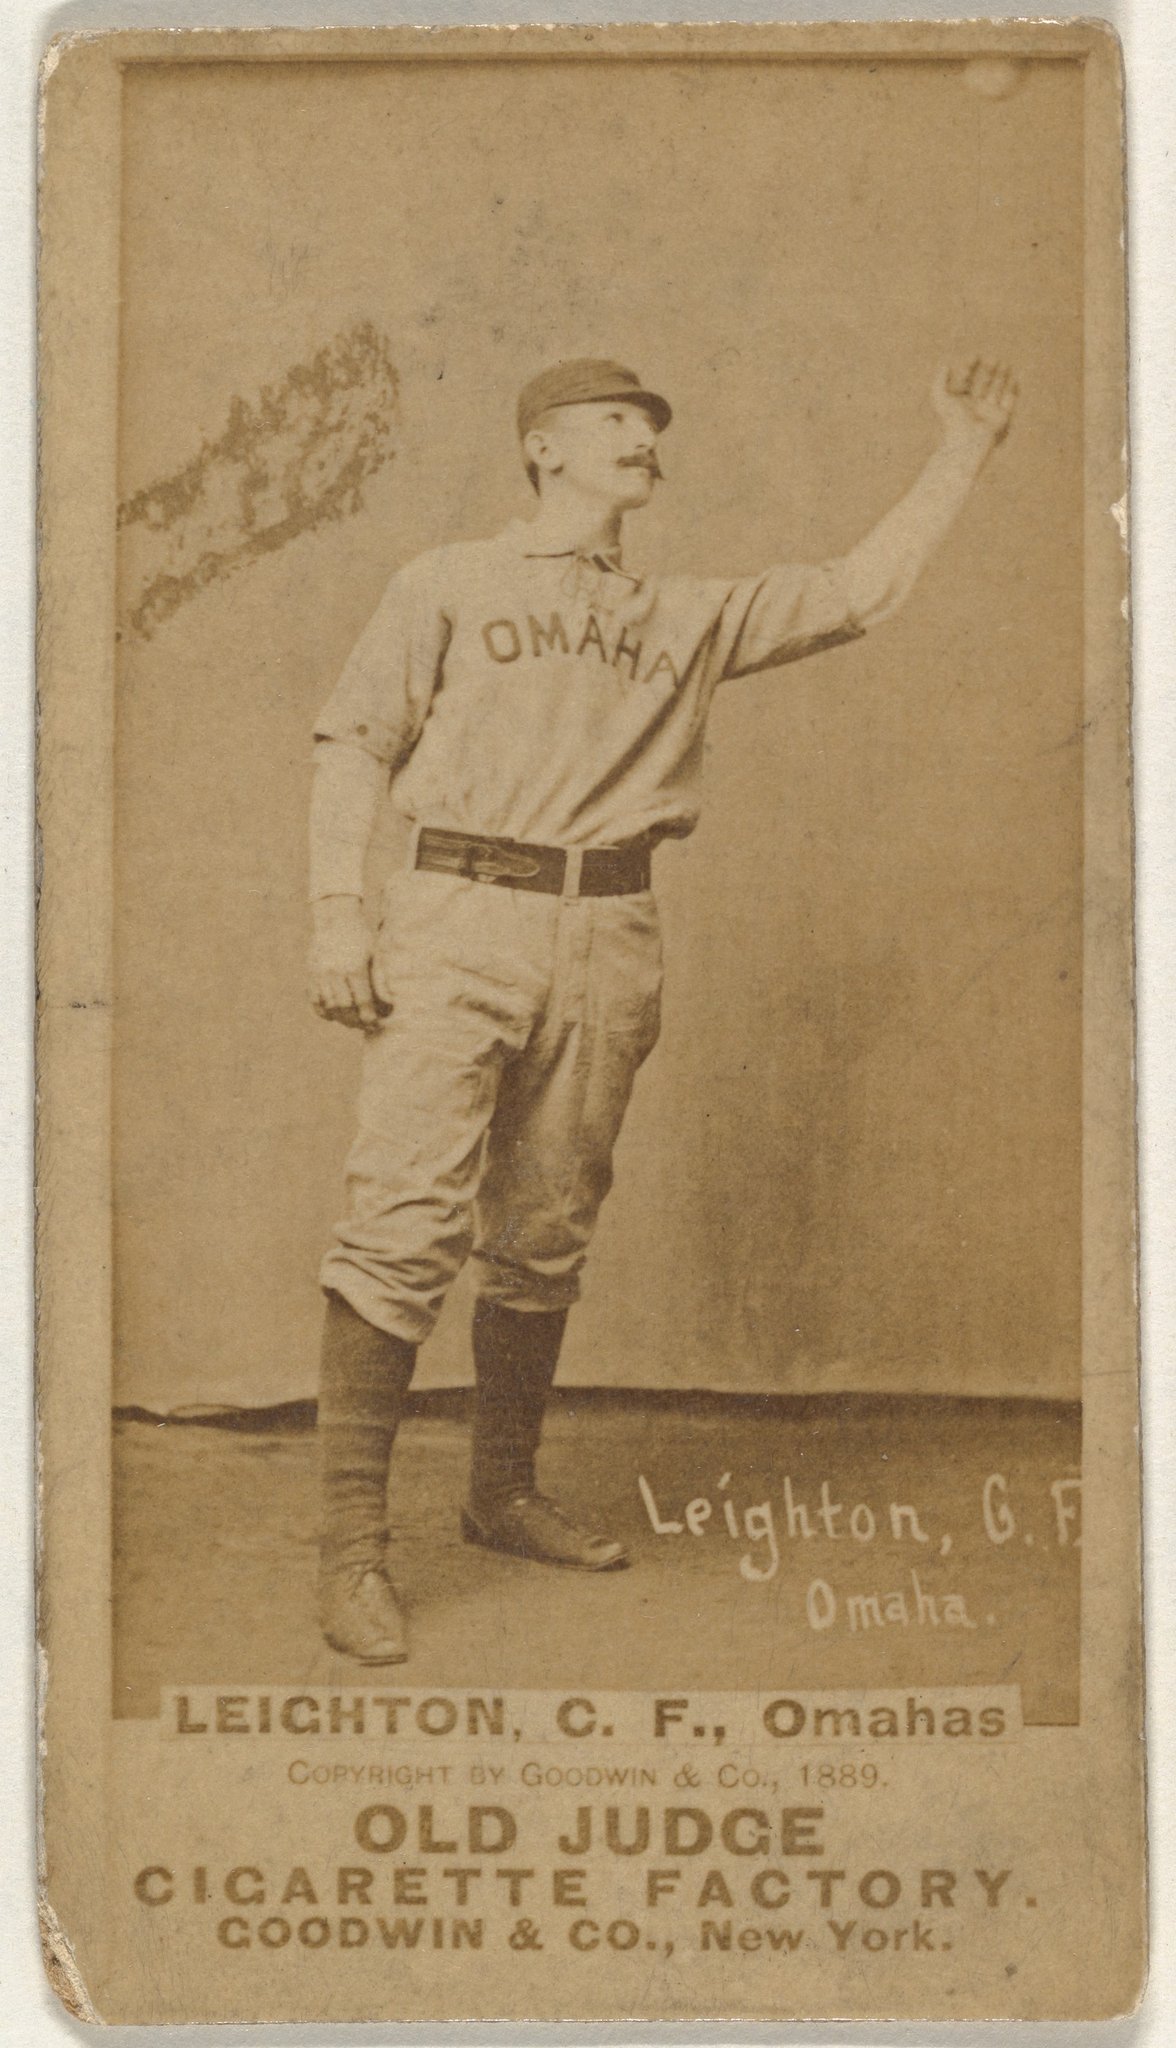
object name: baseball card, photograph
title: Leighton, Center Field, Omaha Omahogs/ Lambs, from the Old Judge series (N172) for Old Judge Cigarettes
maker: goodwin & company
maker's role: publisher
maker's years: 1850-1950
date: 1889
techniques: albumen silver print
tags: men,portraits,baseball,athletes